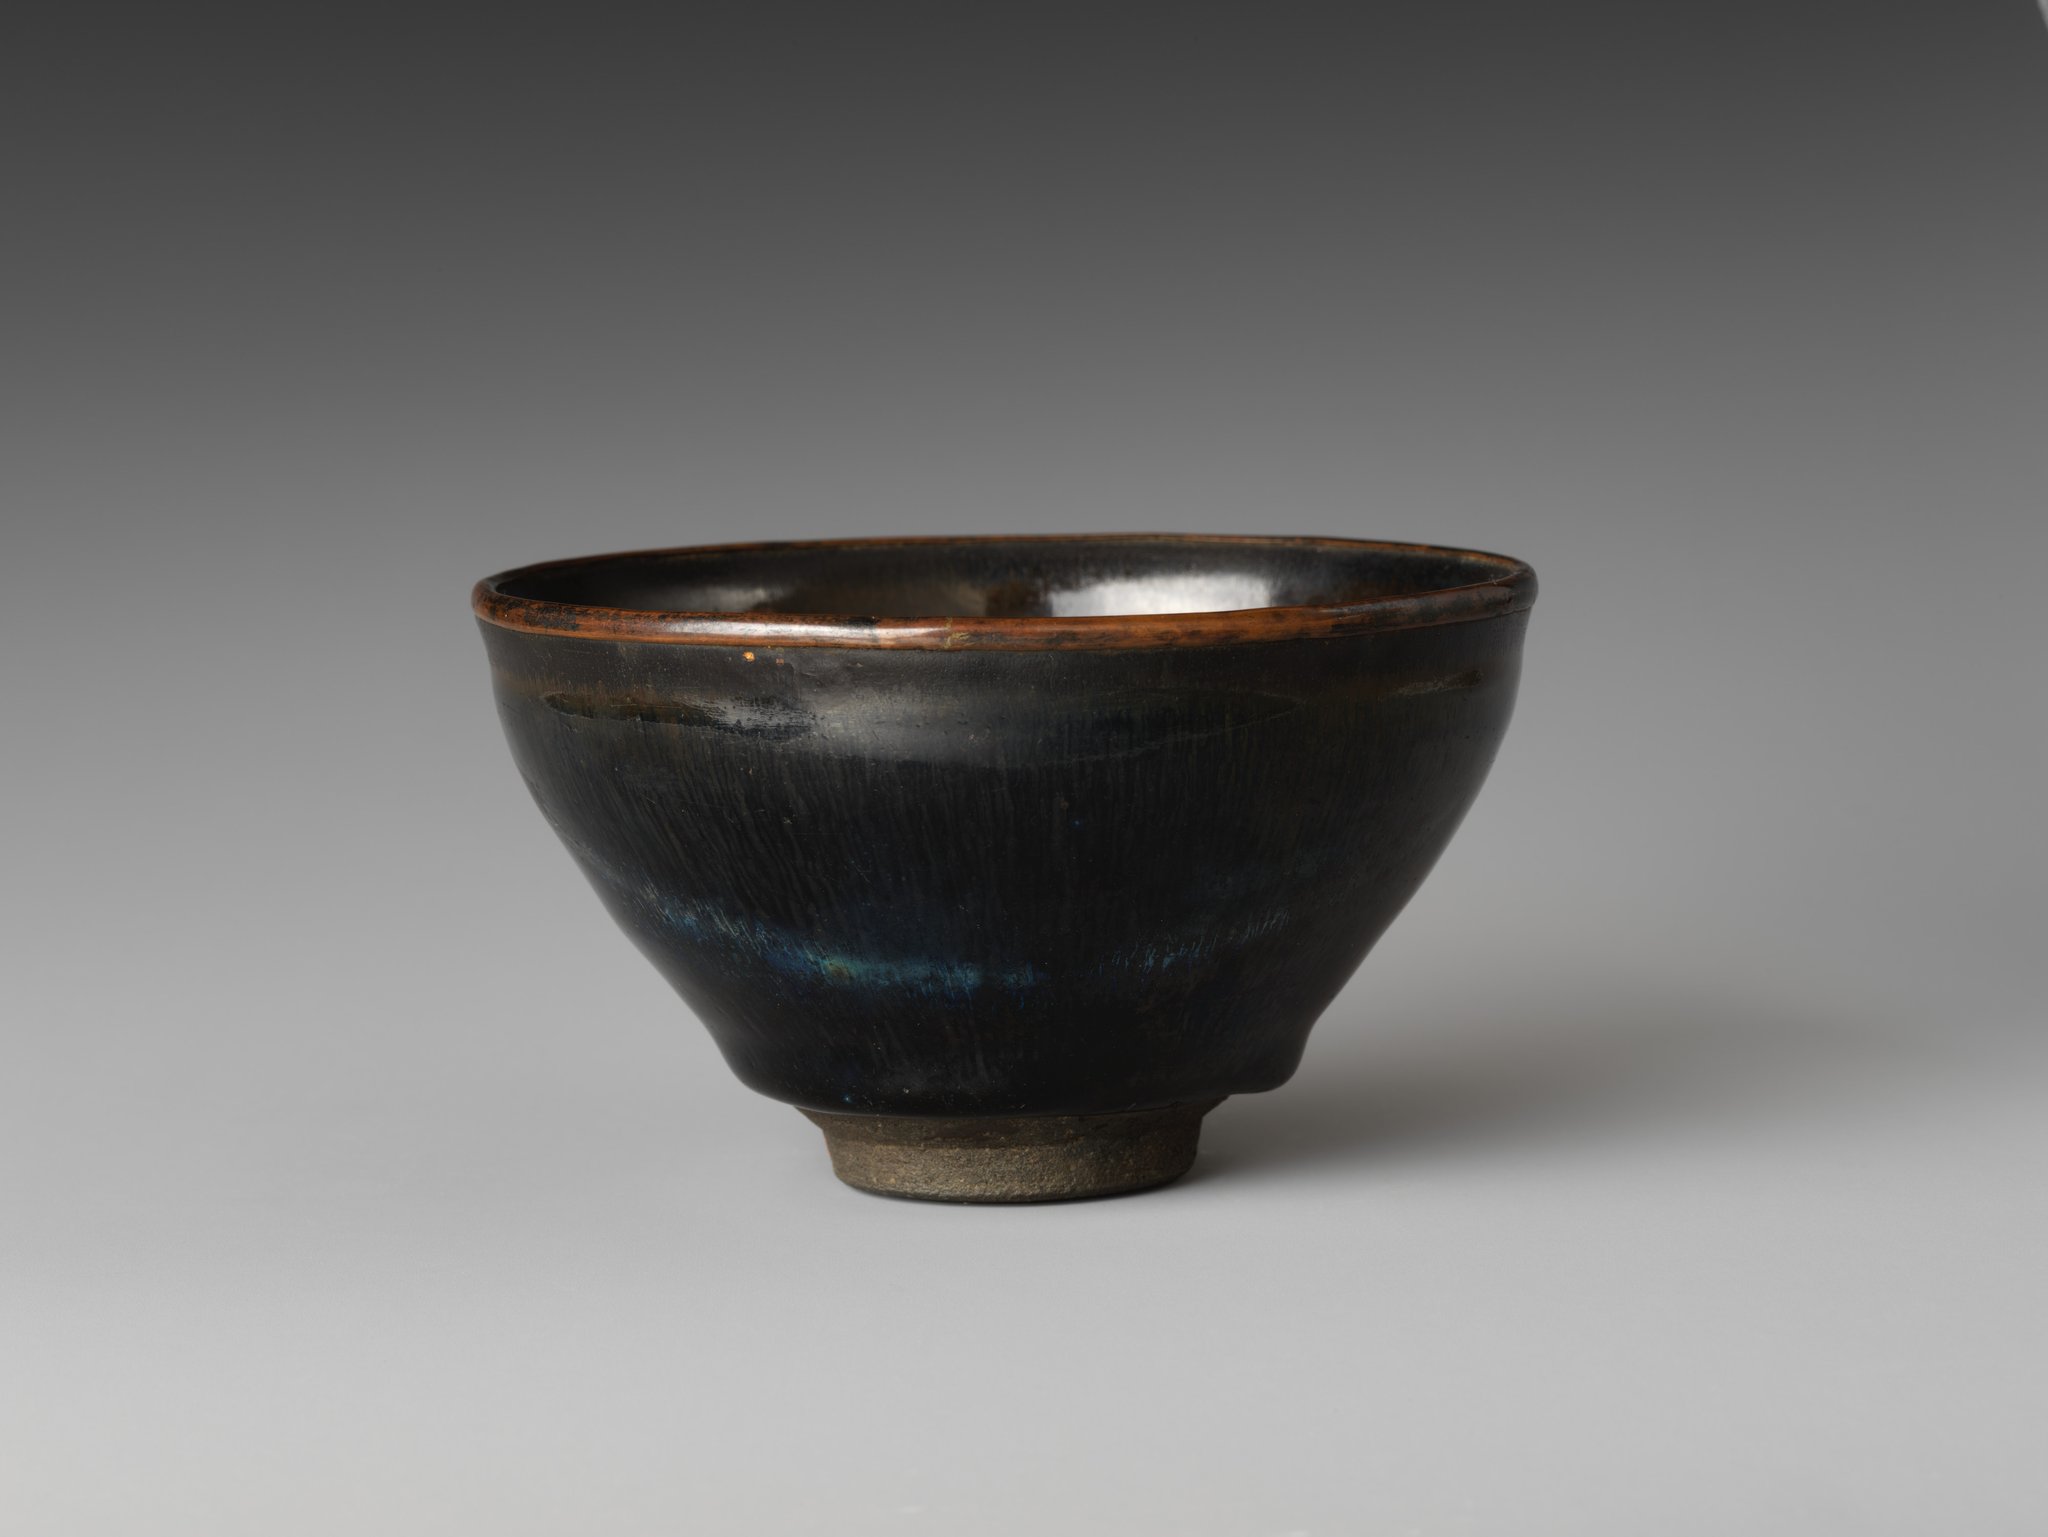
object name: tea bowl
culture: chinese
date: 1101-1300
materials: fur, glaze, stoneware